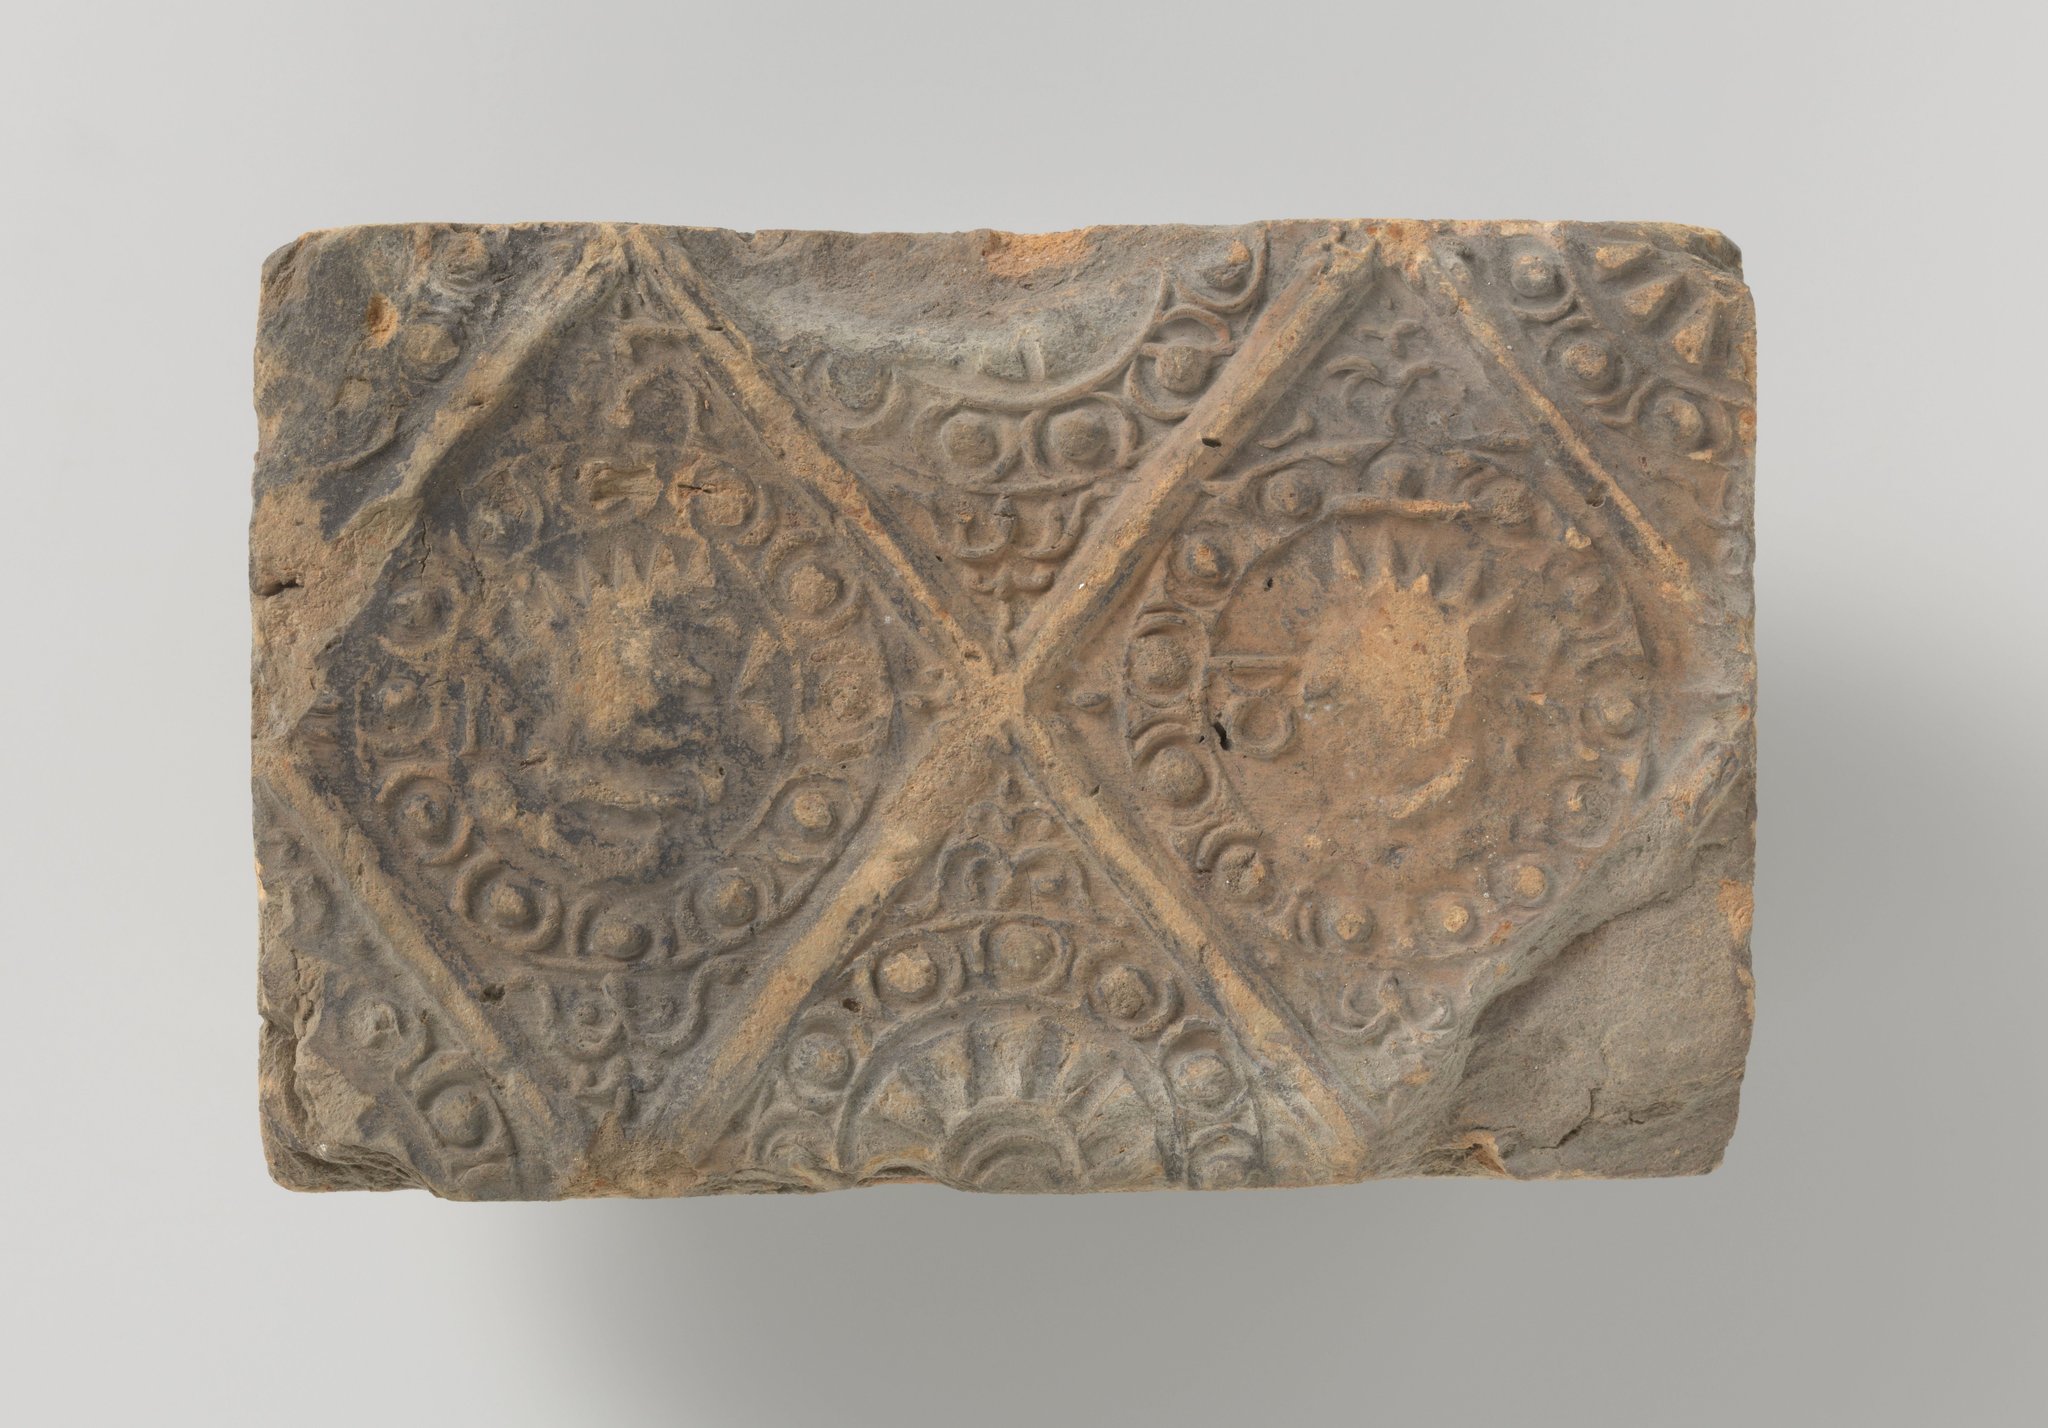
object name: hearthstone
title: Haardsteen met voorstelling van een mannen- en een vrouwenkop, geplaatst in twee ruiten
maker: Anonymous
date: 1585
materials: earthenware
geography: southern netherlands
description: Haardsteen met voorstelling van een mannen- en een vrouwenkop, geplaatst in twee ruiten en vergezeld van het jaartal 1585.